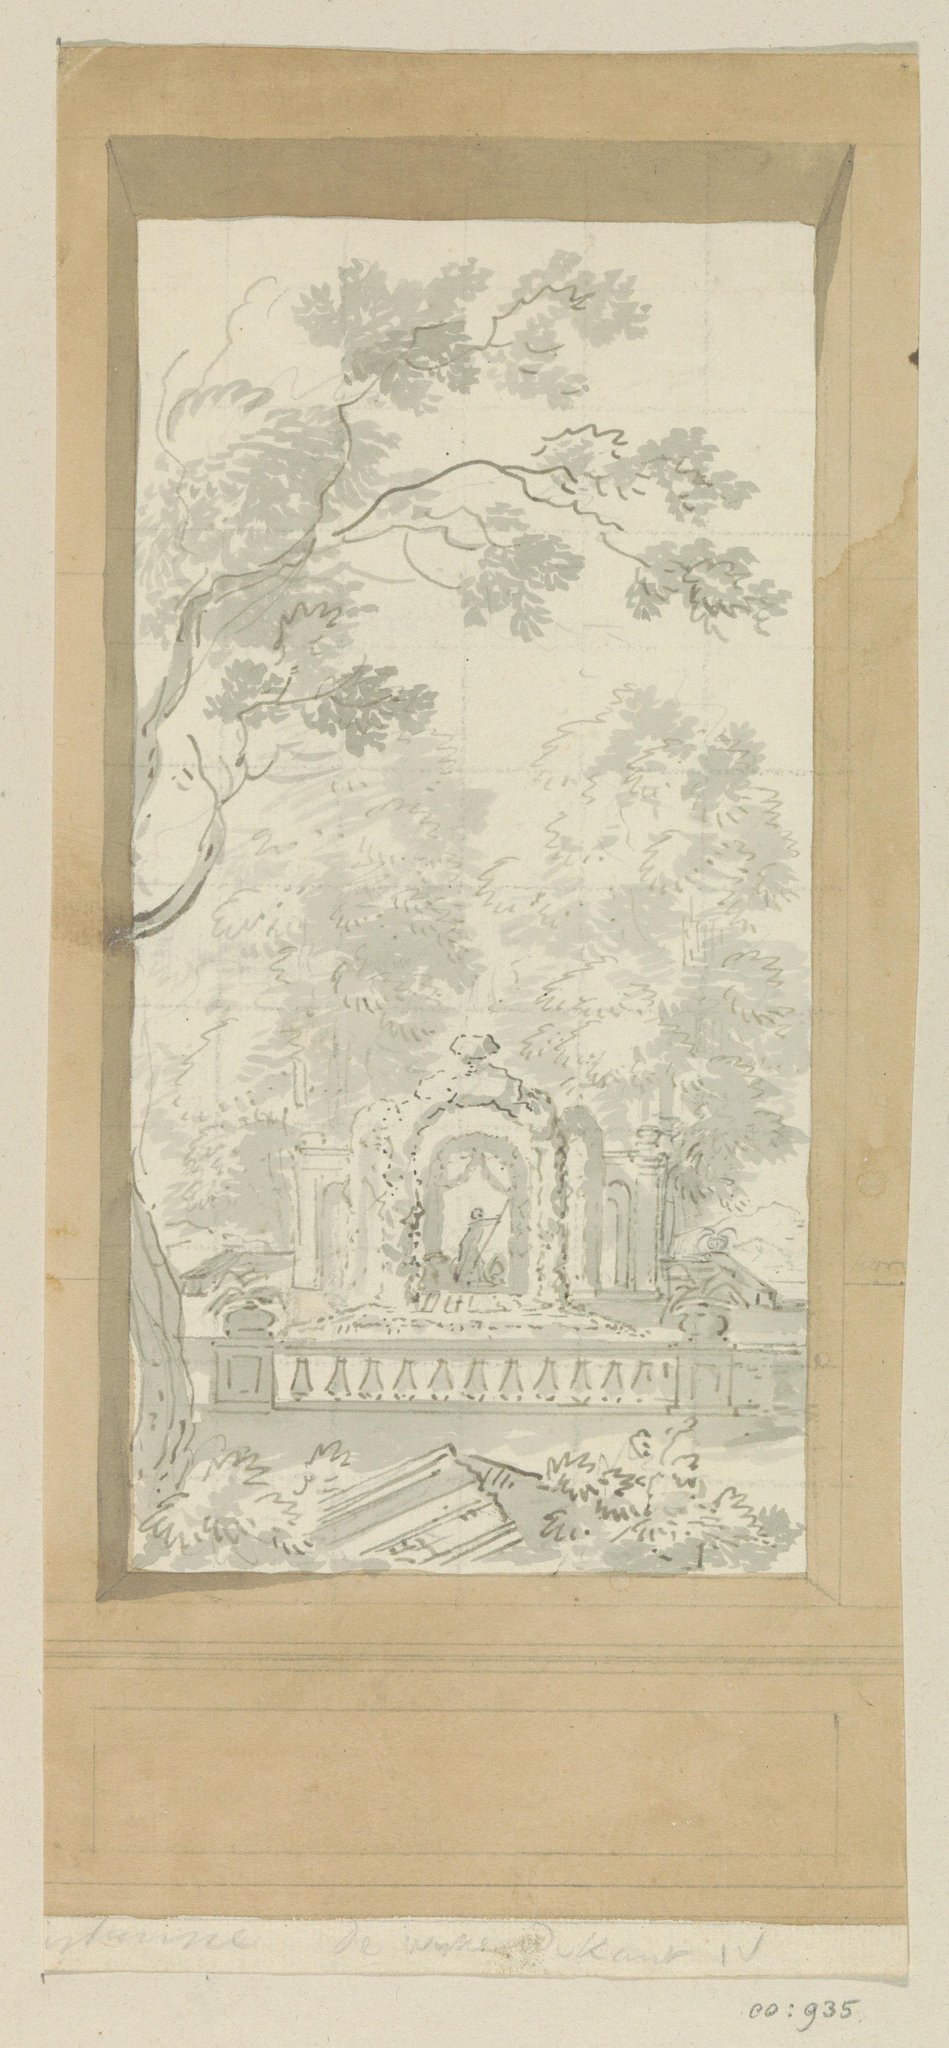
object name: album leaf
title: Ontwerptekening voor een kamerwand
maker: jurriaan andriessen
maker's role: draughtsman, painter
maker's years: 1742-1819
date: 1760-1819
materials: paper, pencil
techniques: brush, pen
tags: park, garden, wall-covering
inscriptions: inscription: ‘Ebeling?’, inscription: ‘Binnenkamer bij den/ H. E. Ebeling’, inscription: ‘[...] de wy[...] kamer[?/kant?] IV’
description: Met een gezicht op een tuin of park met een balustrade en een ornament. Met op de achtergrond een raster. Tekening maakt deel uit van een album.